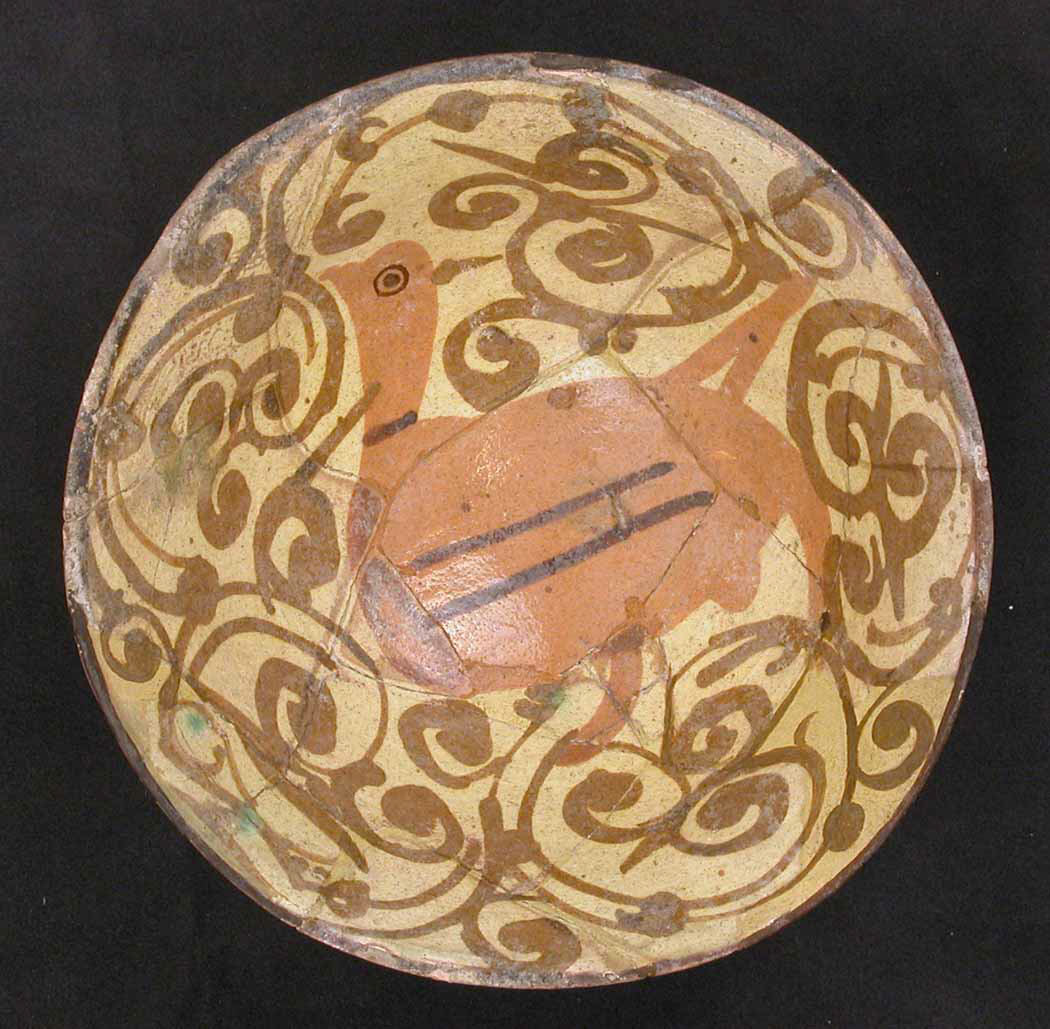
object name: bowl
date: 901-1100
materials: earthenware, glaze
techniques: painting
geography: iran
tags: birds